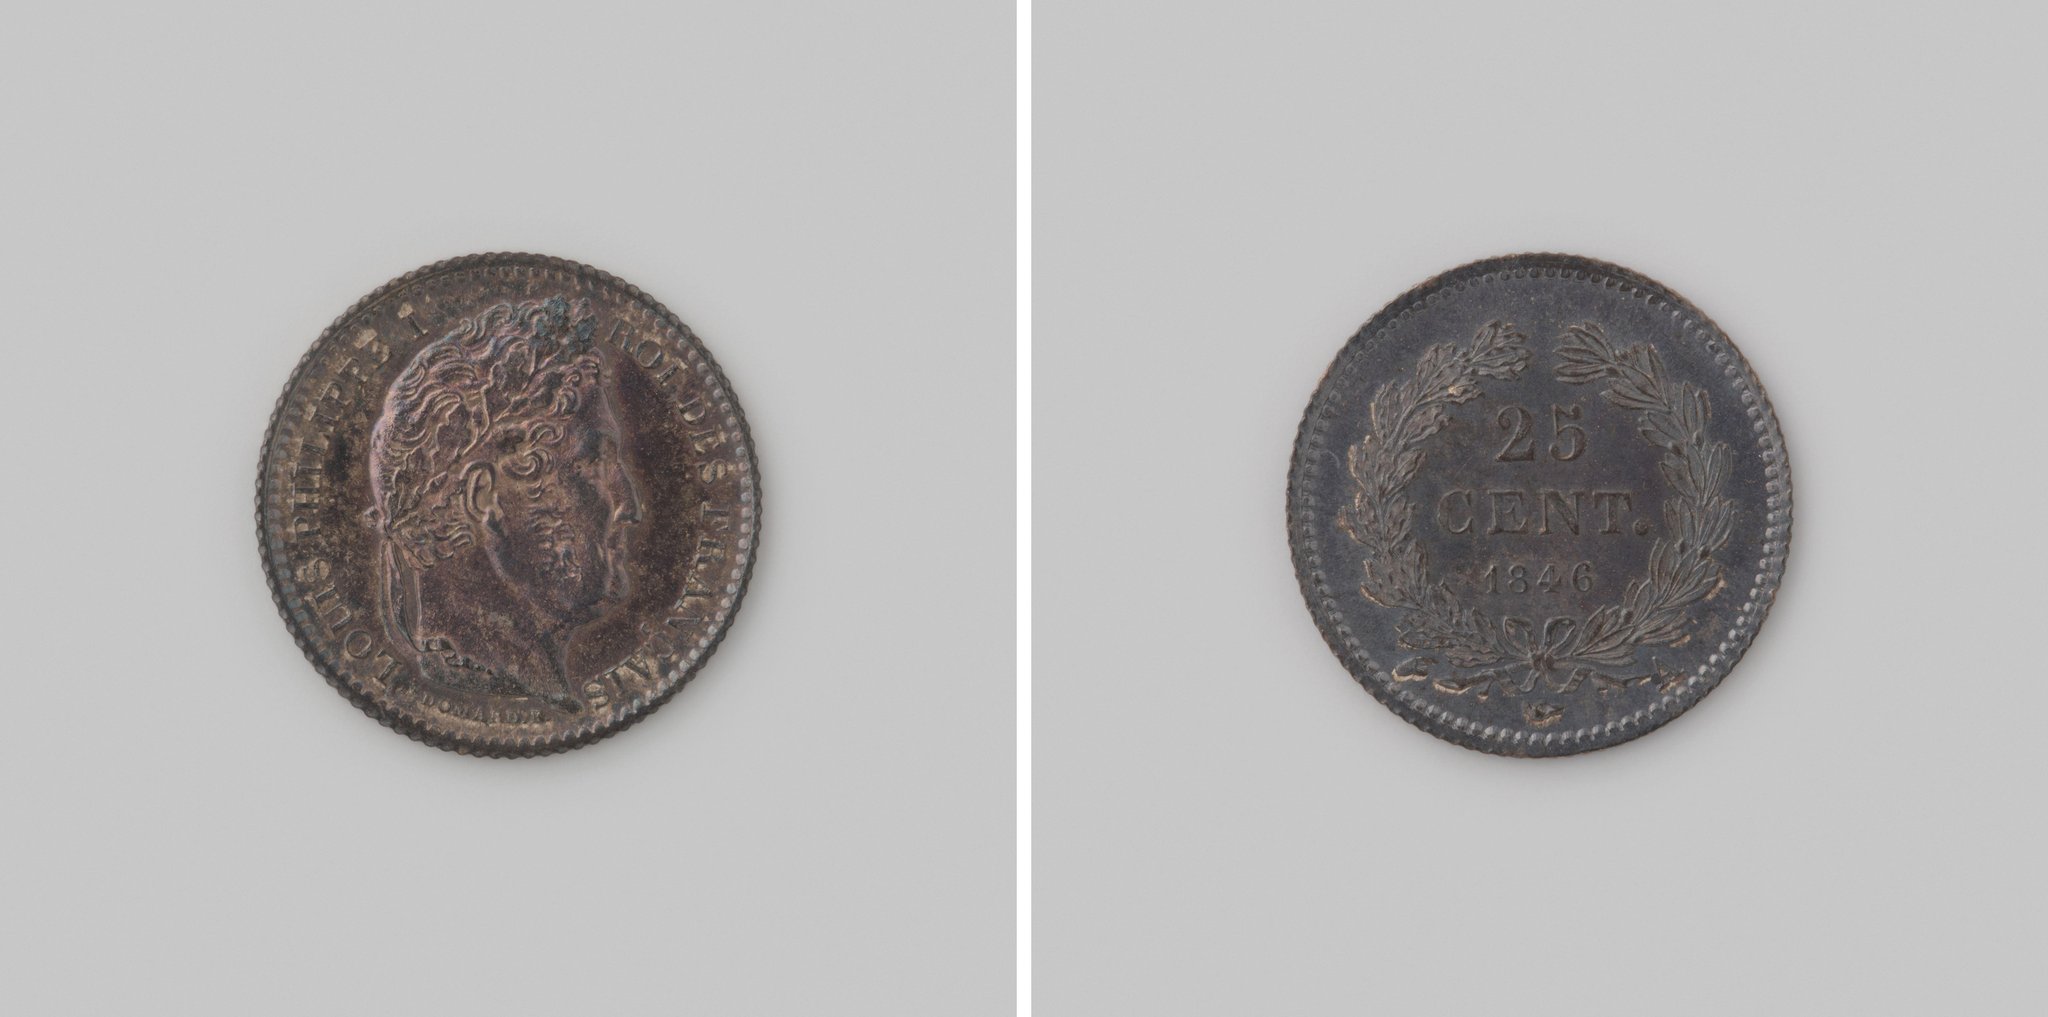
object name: coin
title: Koninkrijk Frankrijk, Louis Philippe I, 25 centimes, 1846 A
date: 1841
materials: silver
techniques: striking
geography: paris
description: Zilveren munt. Voorzijde: hoofd van de koning met krans van eikenbladeren naar rechts. Keerzijde: binnen twee samengebonden lauriertakken waarde-aanduiding in twee regels, waaronder jaartal. Onderaan rechts letter A [=Parijs]. Kartelrand.